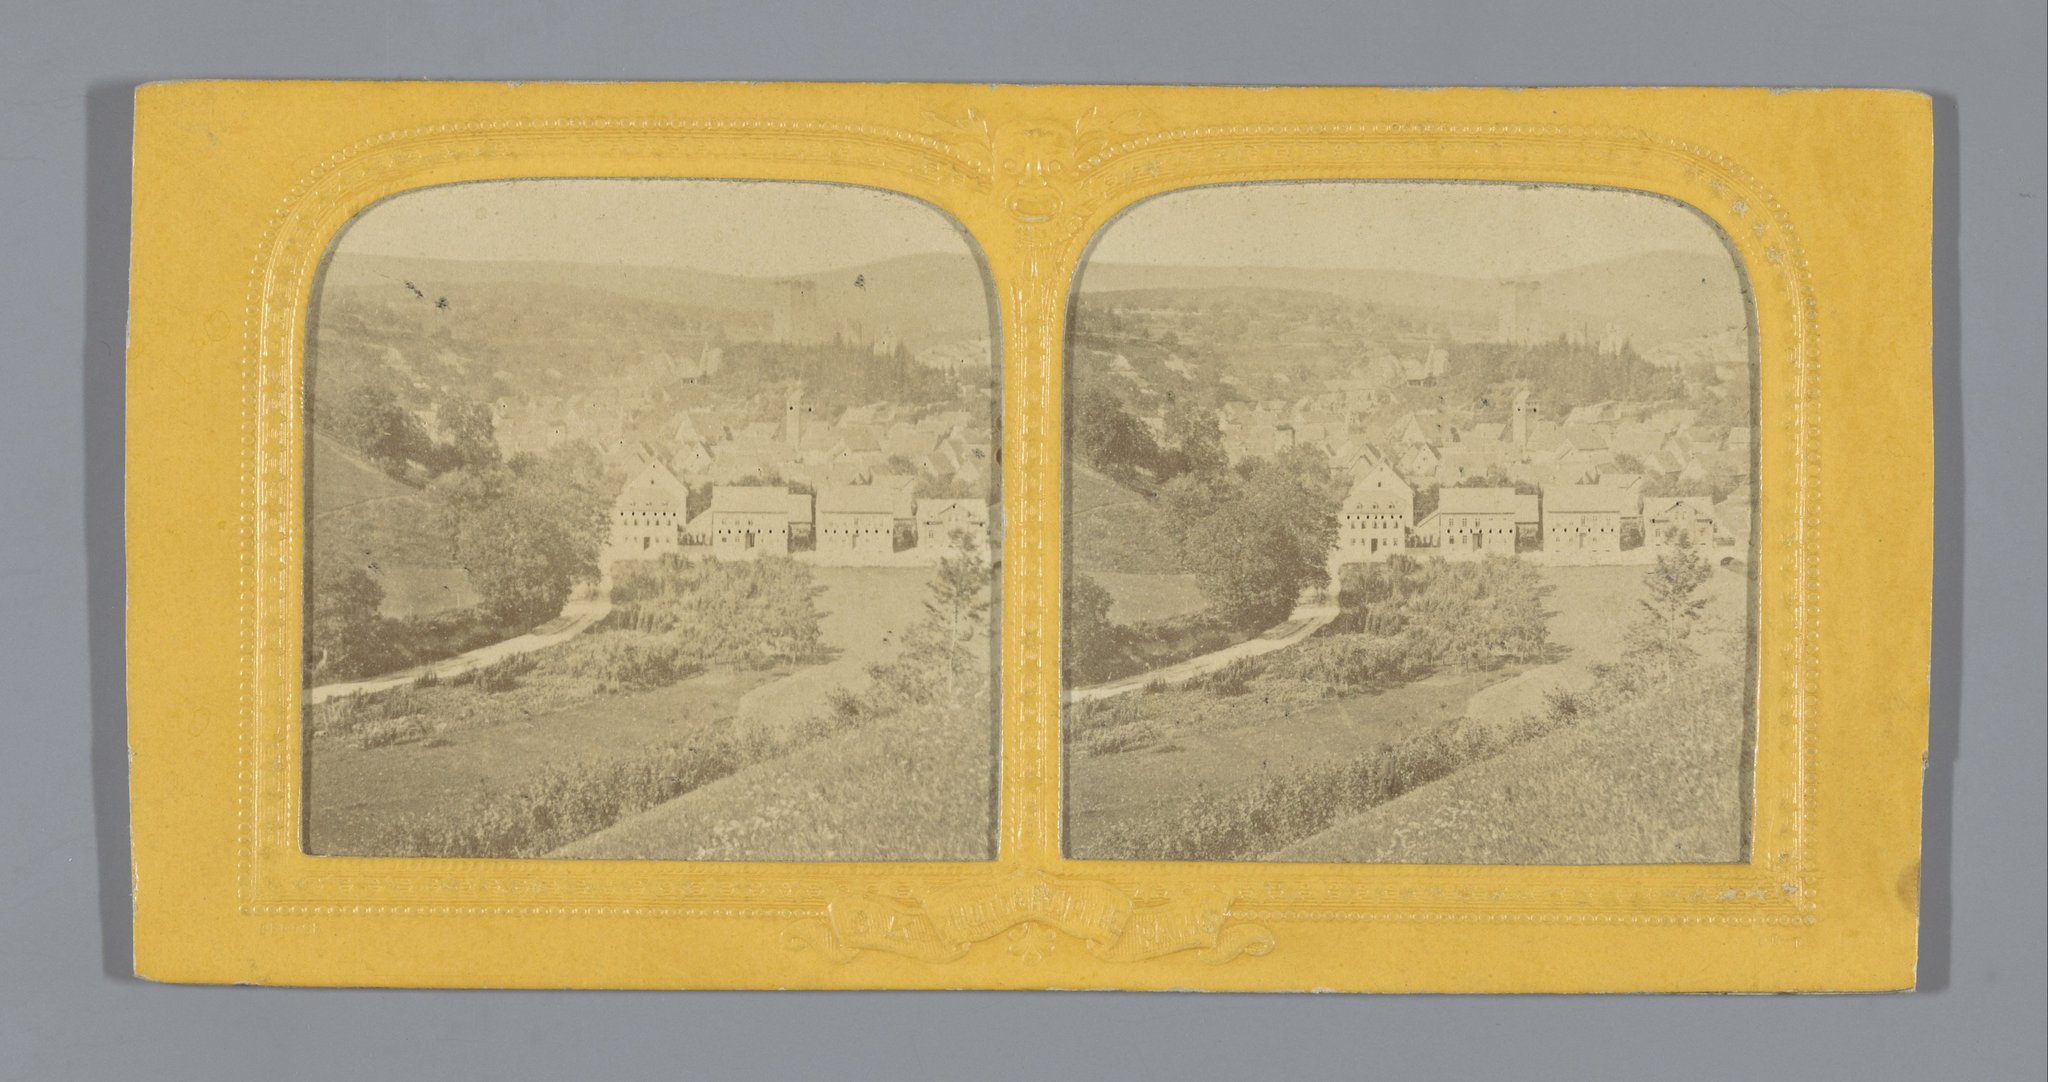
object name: tissue stereograph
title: Sommerberg, Panorama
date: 1864-1880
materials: cardboard, paper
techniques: albumen print, hand coloring, perforating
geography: paris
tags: city-view in general; 'veduta'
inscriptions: inscription: ‘Déposé’, monogram: ‘B.K. PHOTOGRAPHIE PARIS’, monogram: ‘Ch. D.’, inscription: ‘4’